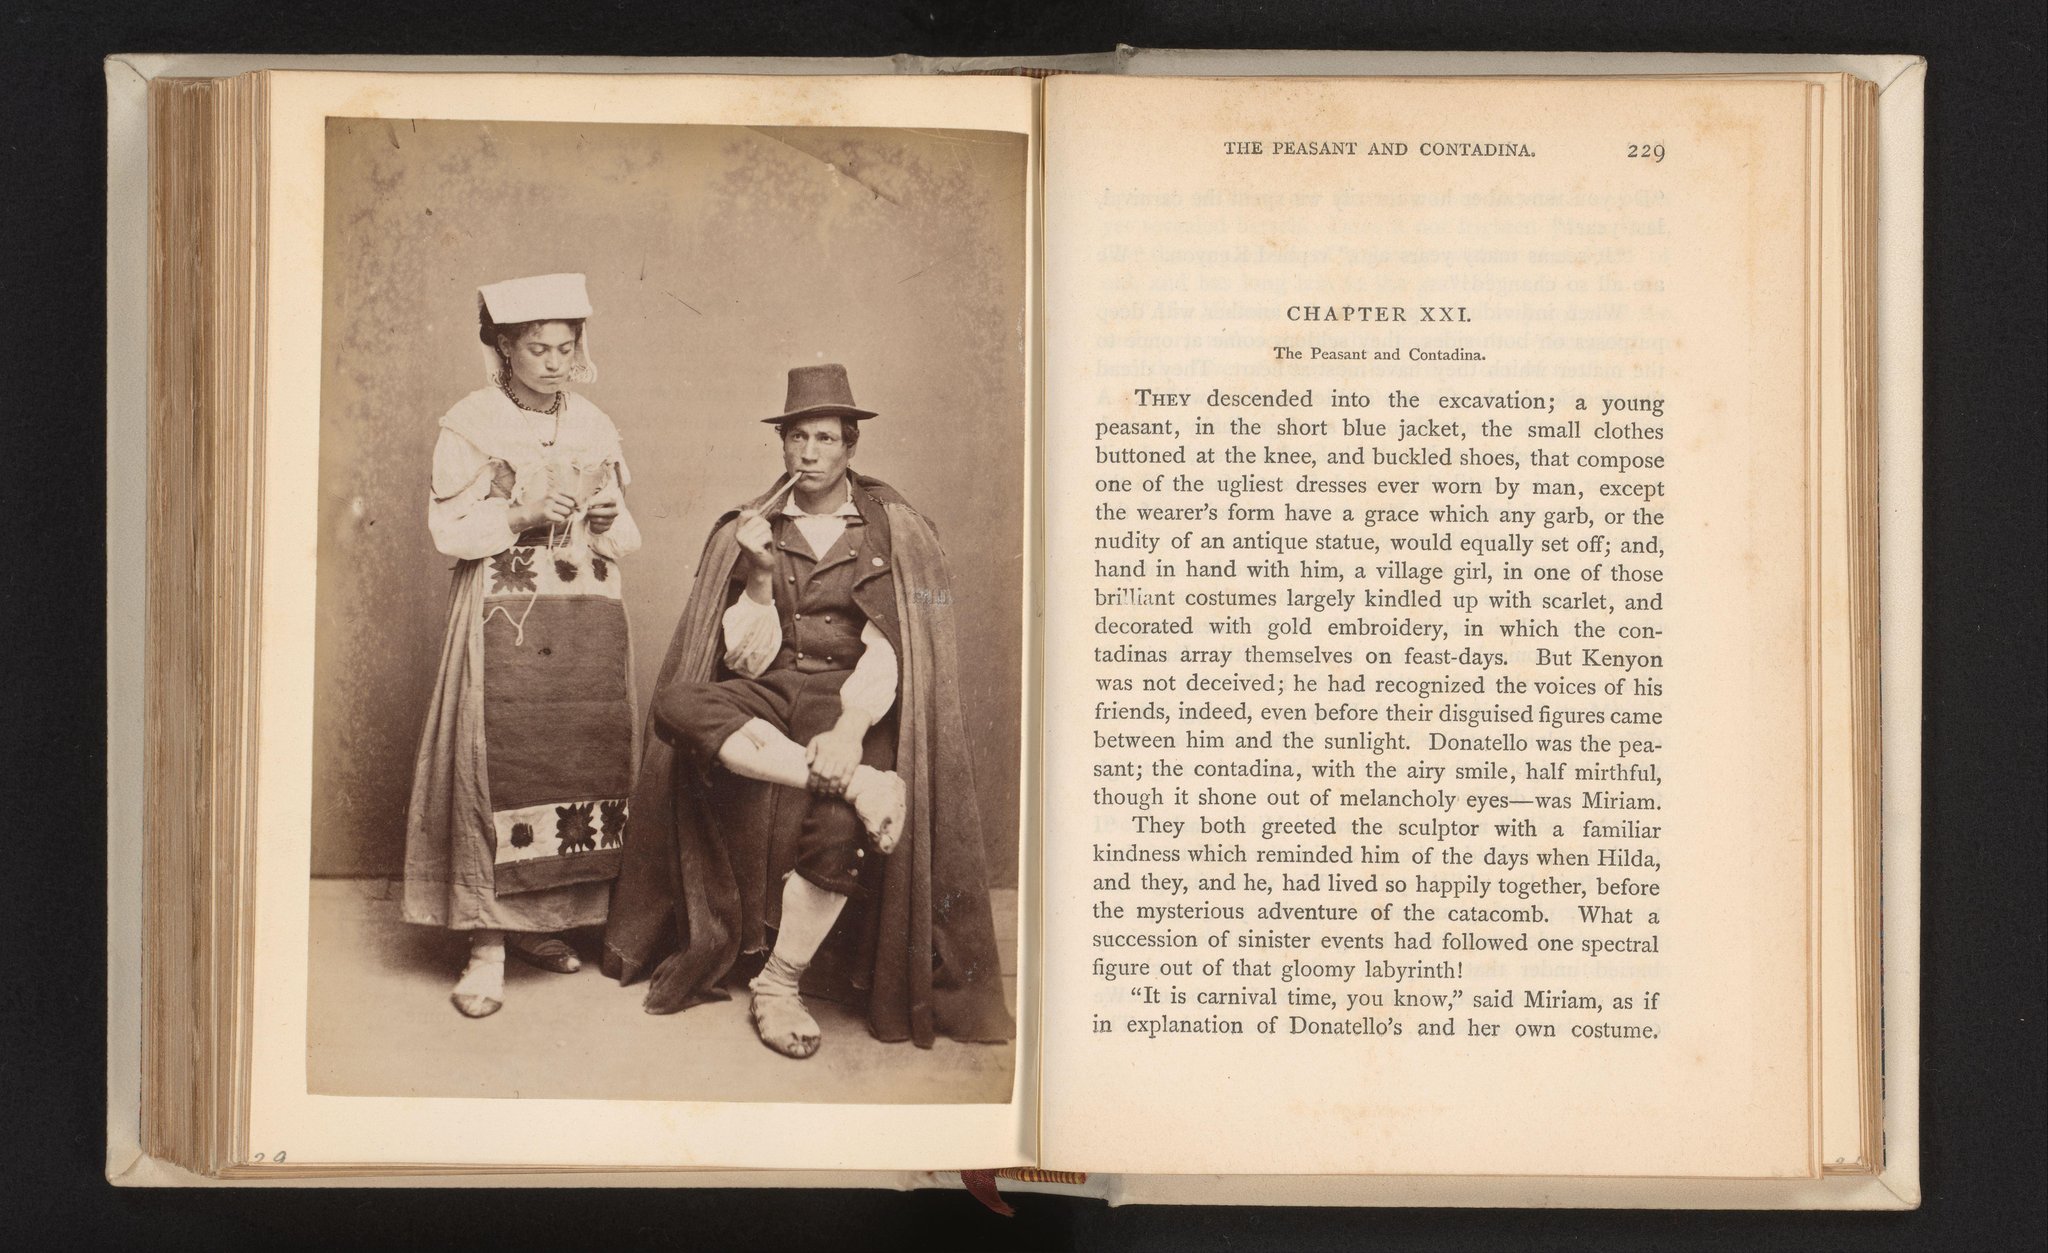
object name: page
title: Portret van een onbekende man en vrouw uit Italië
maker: Anonymous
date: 1850-1860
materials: photographic support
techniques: albumen print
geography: italy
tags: folk costume, regional costume, historical persons not known by name